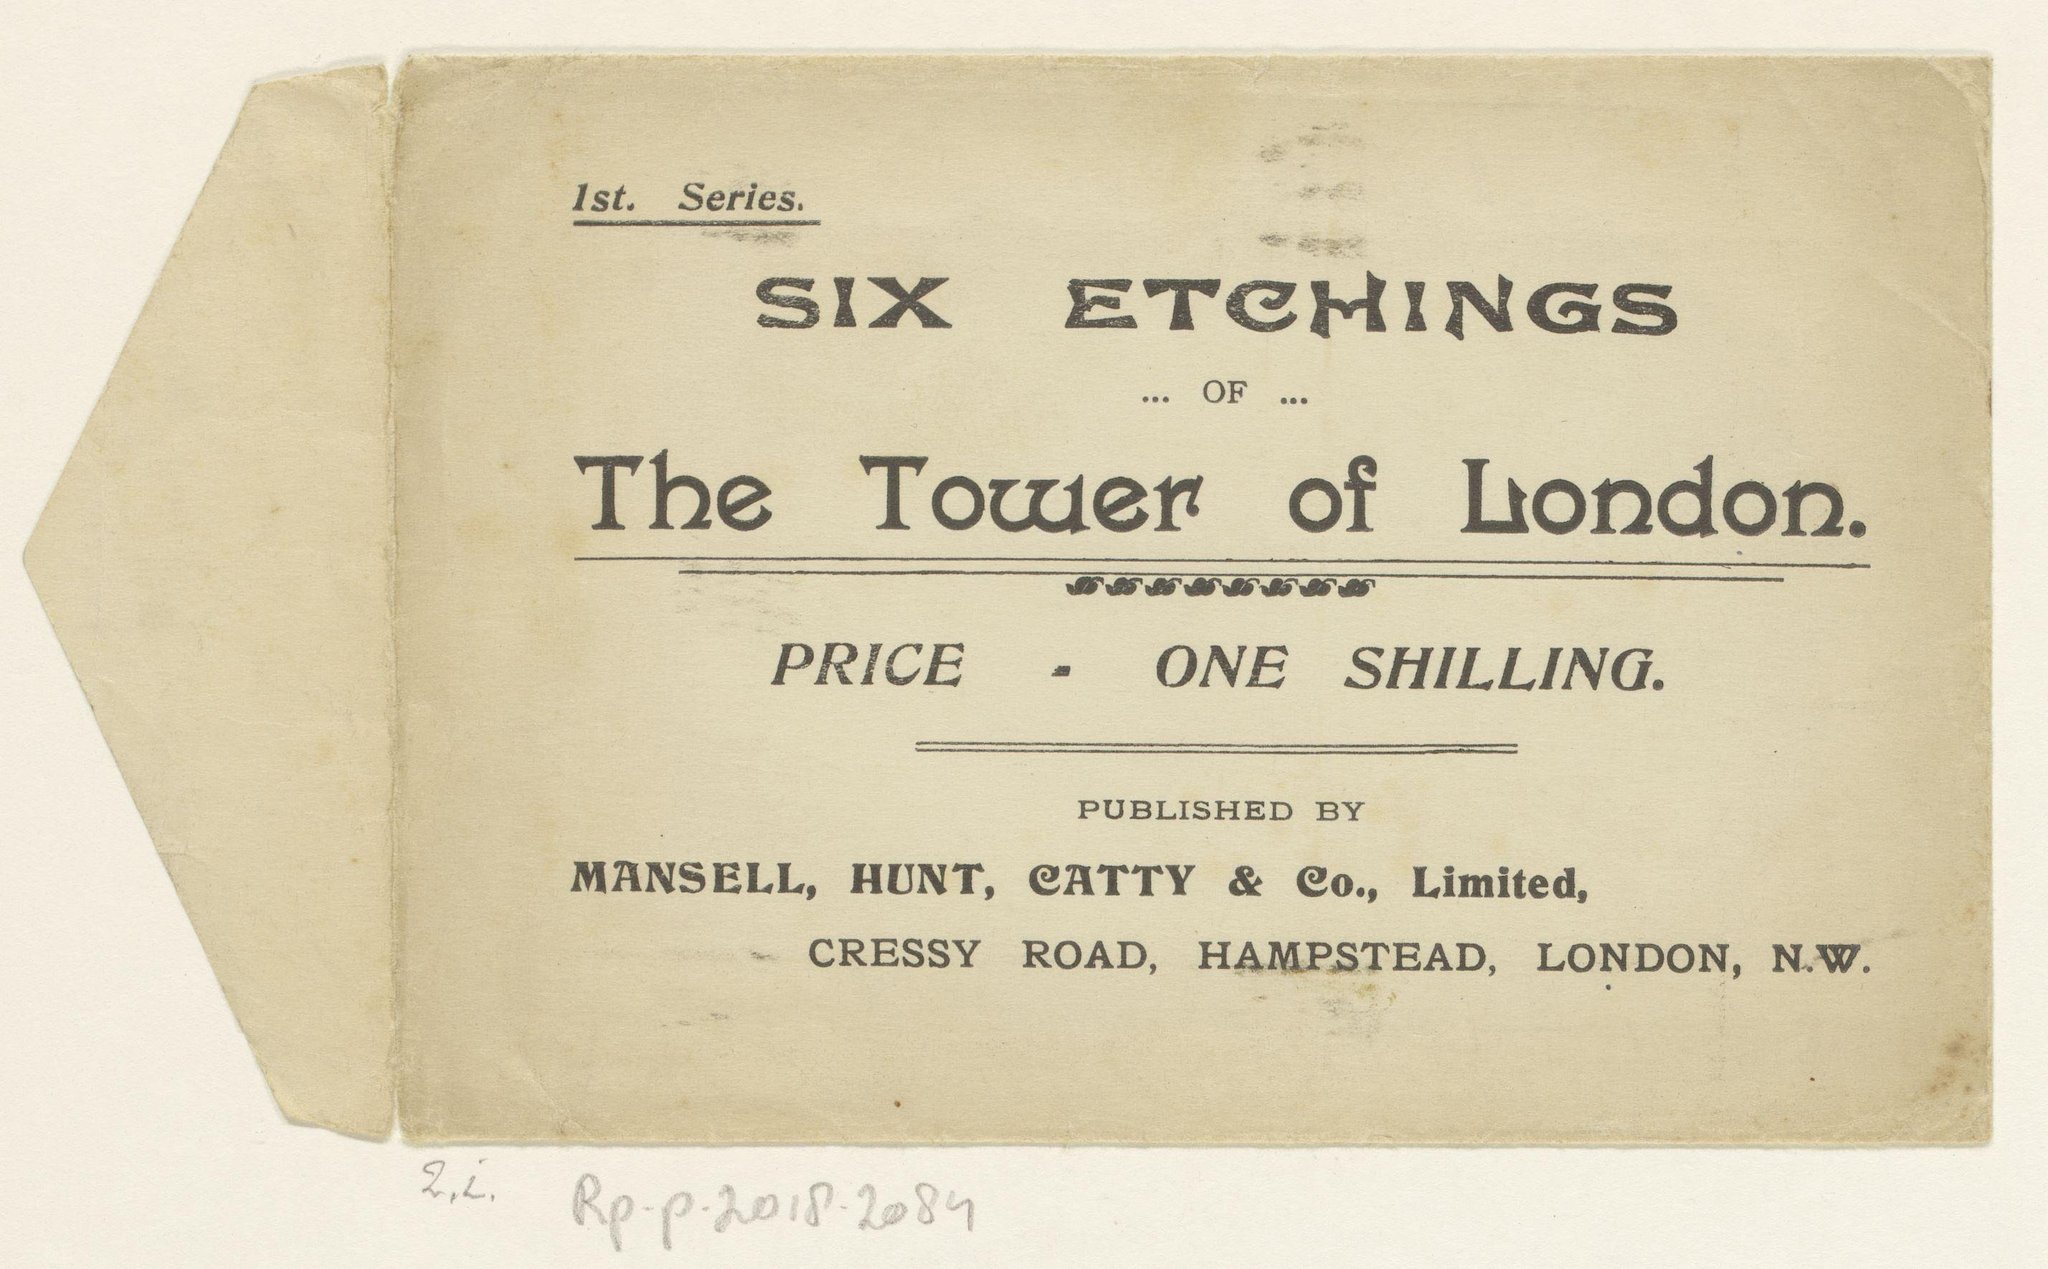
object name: titelprent, frontispice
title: Titelprent voor een serie met etsen van de Tower of London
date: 1850-1949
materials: paper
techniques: letterpress printing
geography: london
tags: tower of london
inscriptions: collector's mark: Lugt 2228